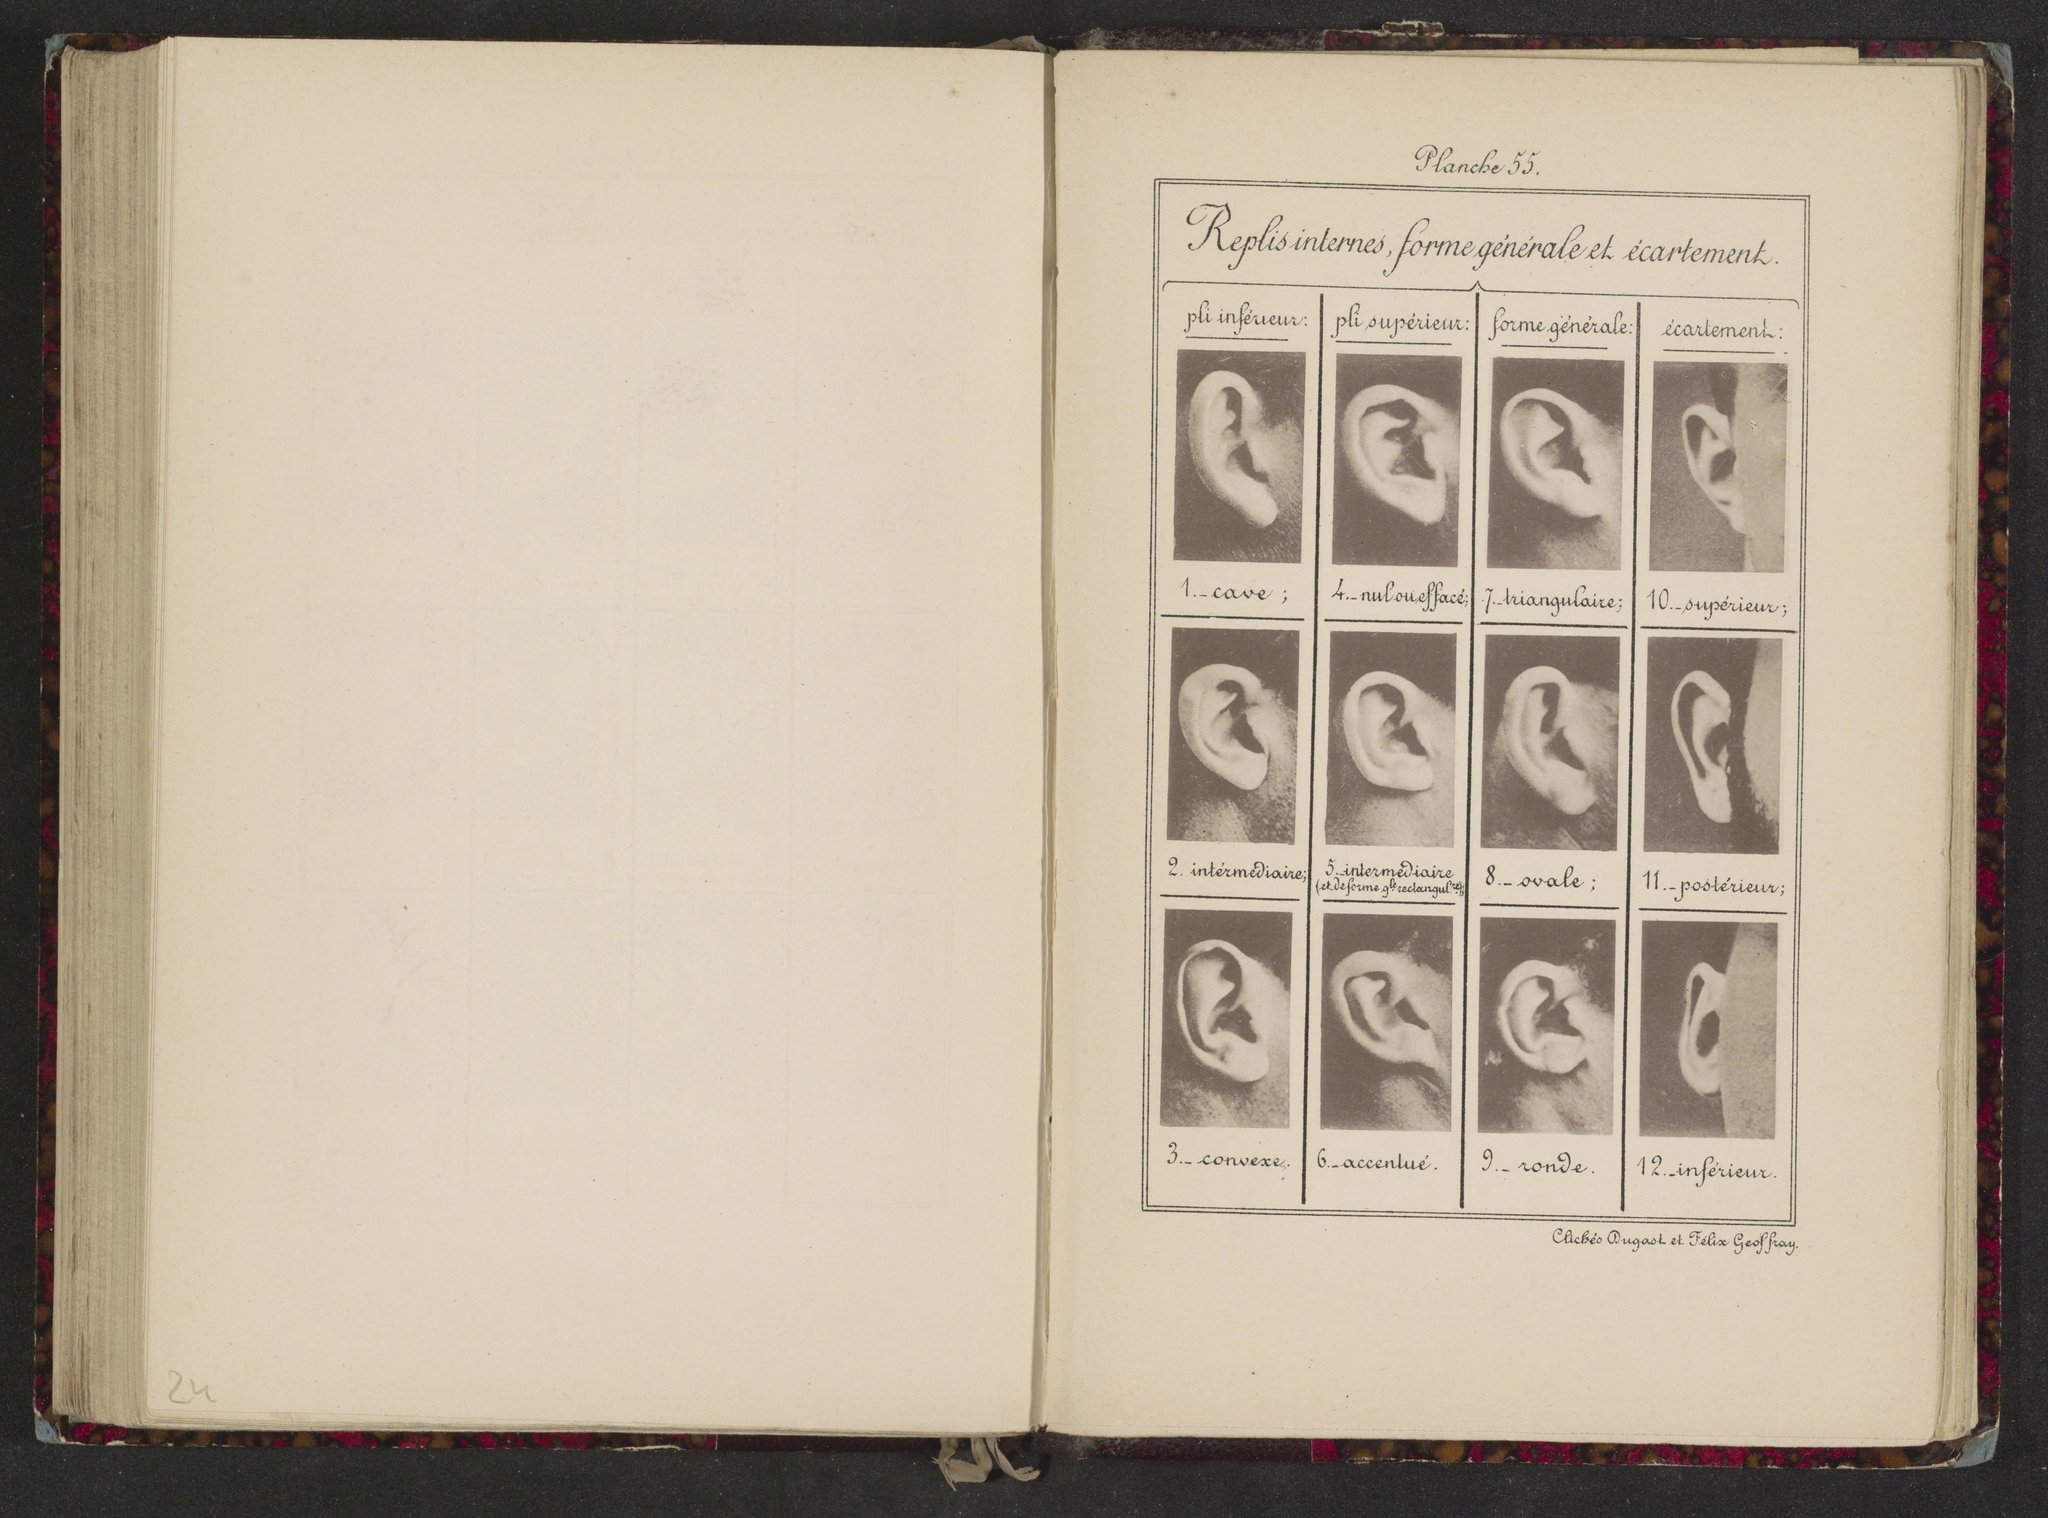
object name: page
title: Replis internes, forme générale et écartement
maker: Anonymous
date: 1880-1893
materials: paper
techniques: photograph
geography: france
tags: ears, france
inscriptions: number: ‘Planche 55.’, number: ‘1. (...) 12.’